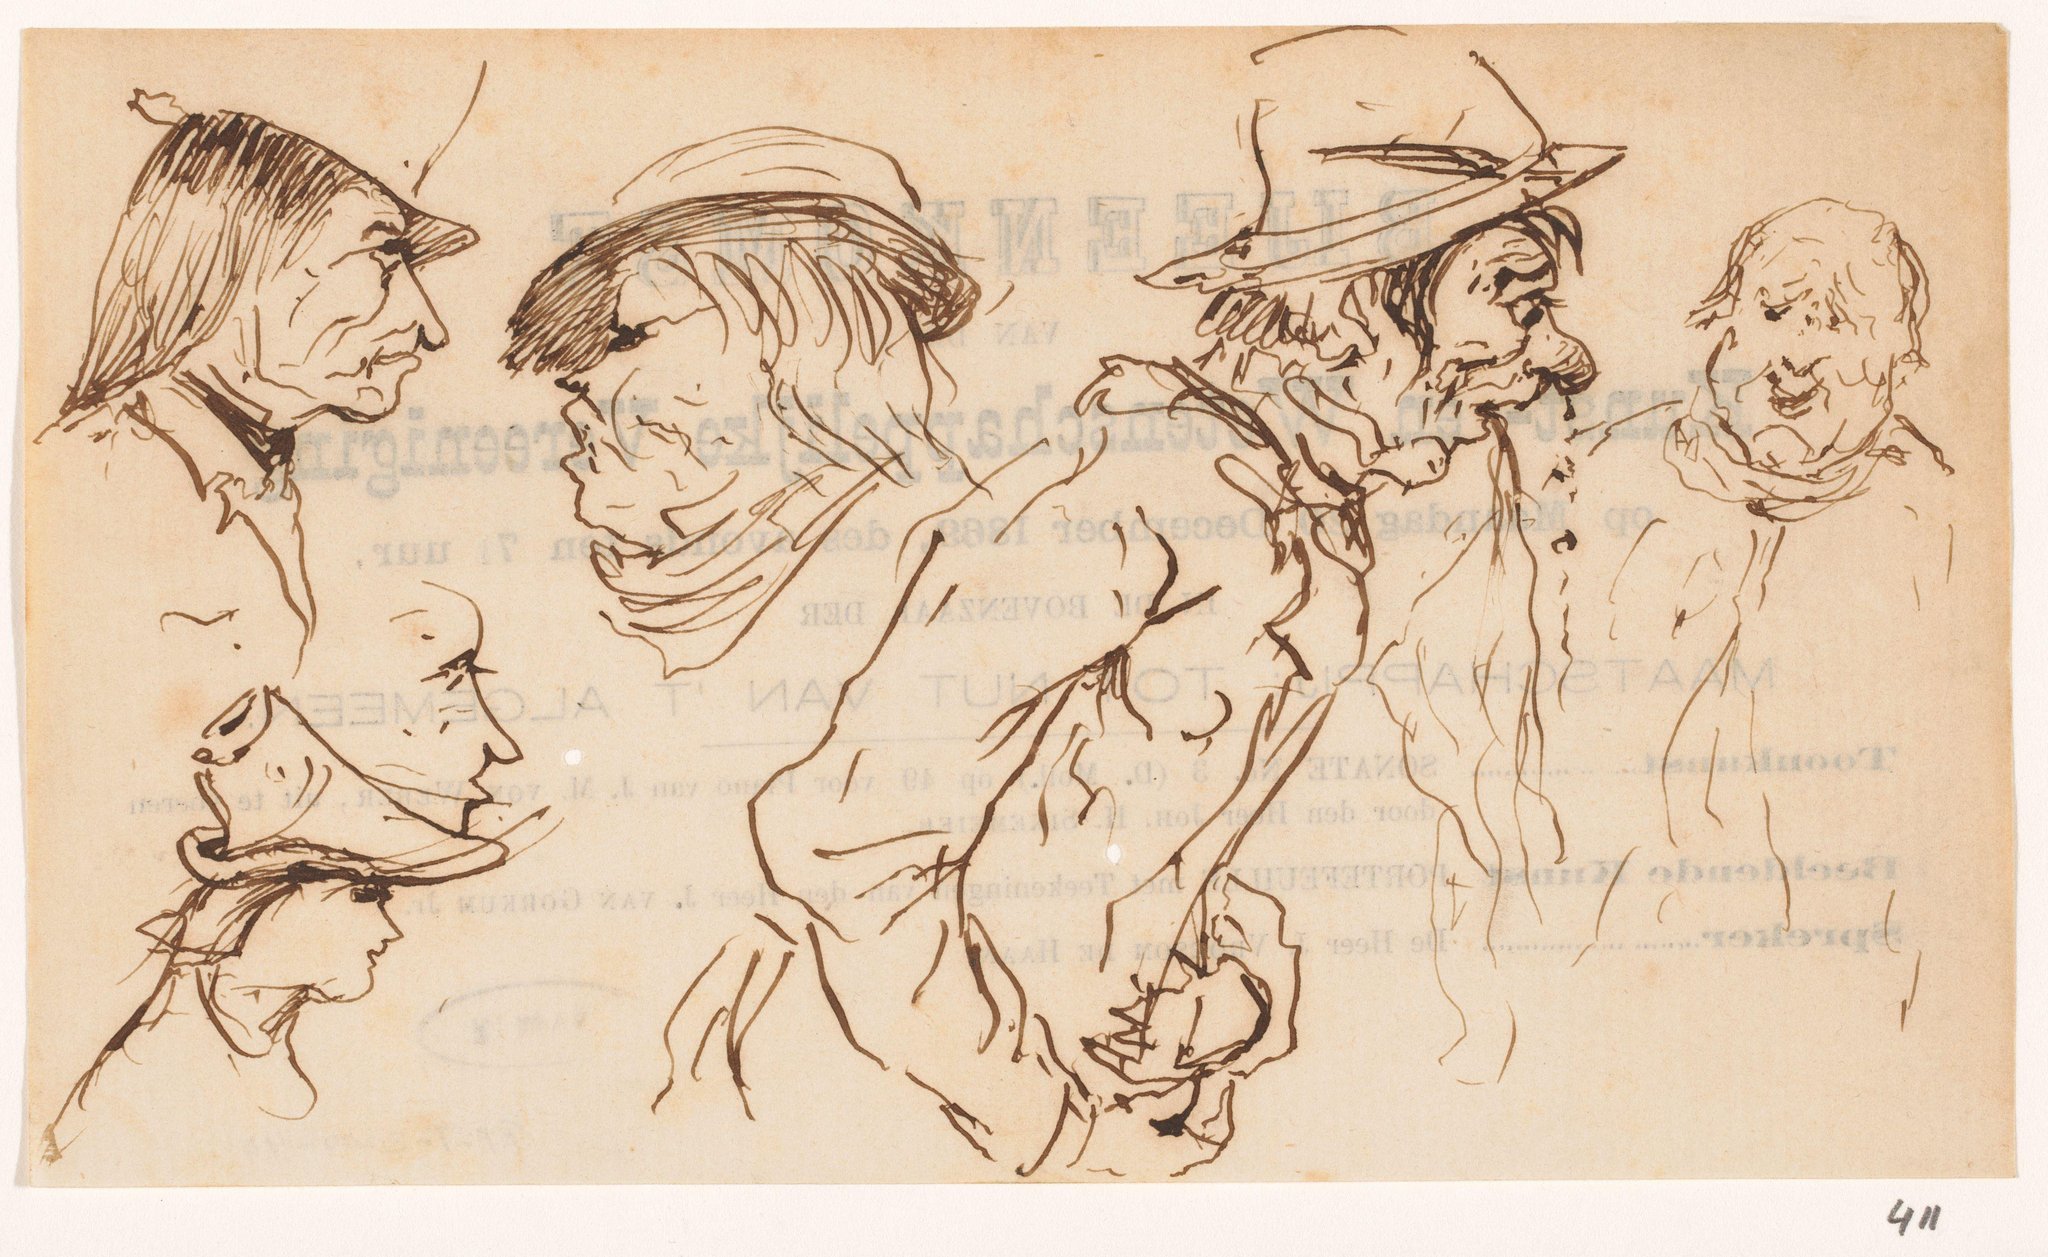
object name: drawing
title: Schetsblad met koppen en overgevende man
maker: johannes tavenraat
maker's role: draughtsman, painter, print maker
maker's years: 1809-1881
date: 1869-1870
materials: ink, paper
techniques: pen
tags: caricatures (human types), vomiting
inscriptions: collector's mark: Lugt 2228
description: Schetsblad met koppen en een overgevende man. Getekend op de achterzijde van een gedrukte uitnodiging voor een 'Bijeenkomst van de Kunst- en Wetenschappelijke Vereeniging' op 20 december 1869.